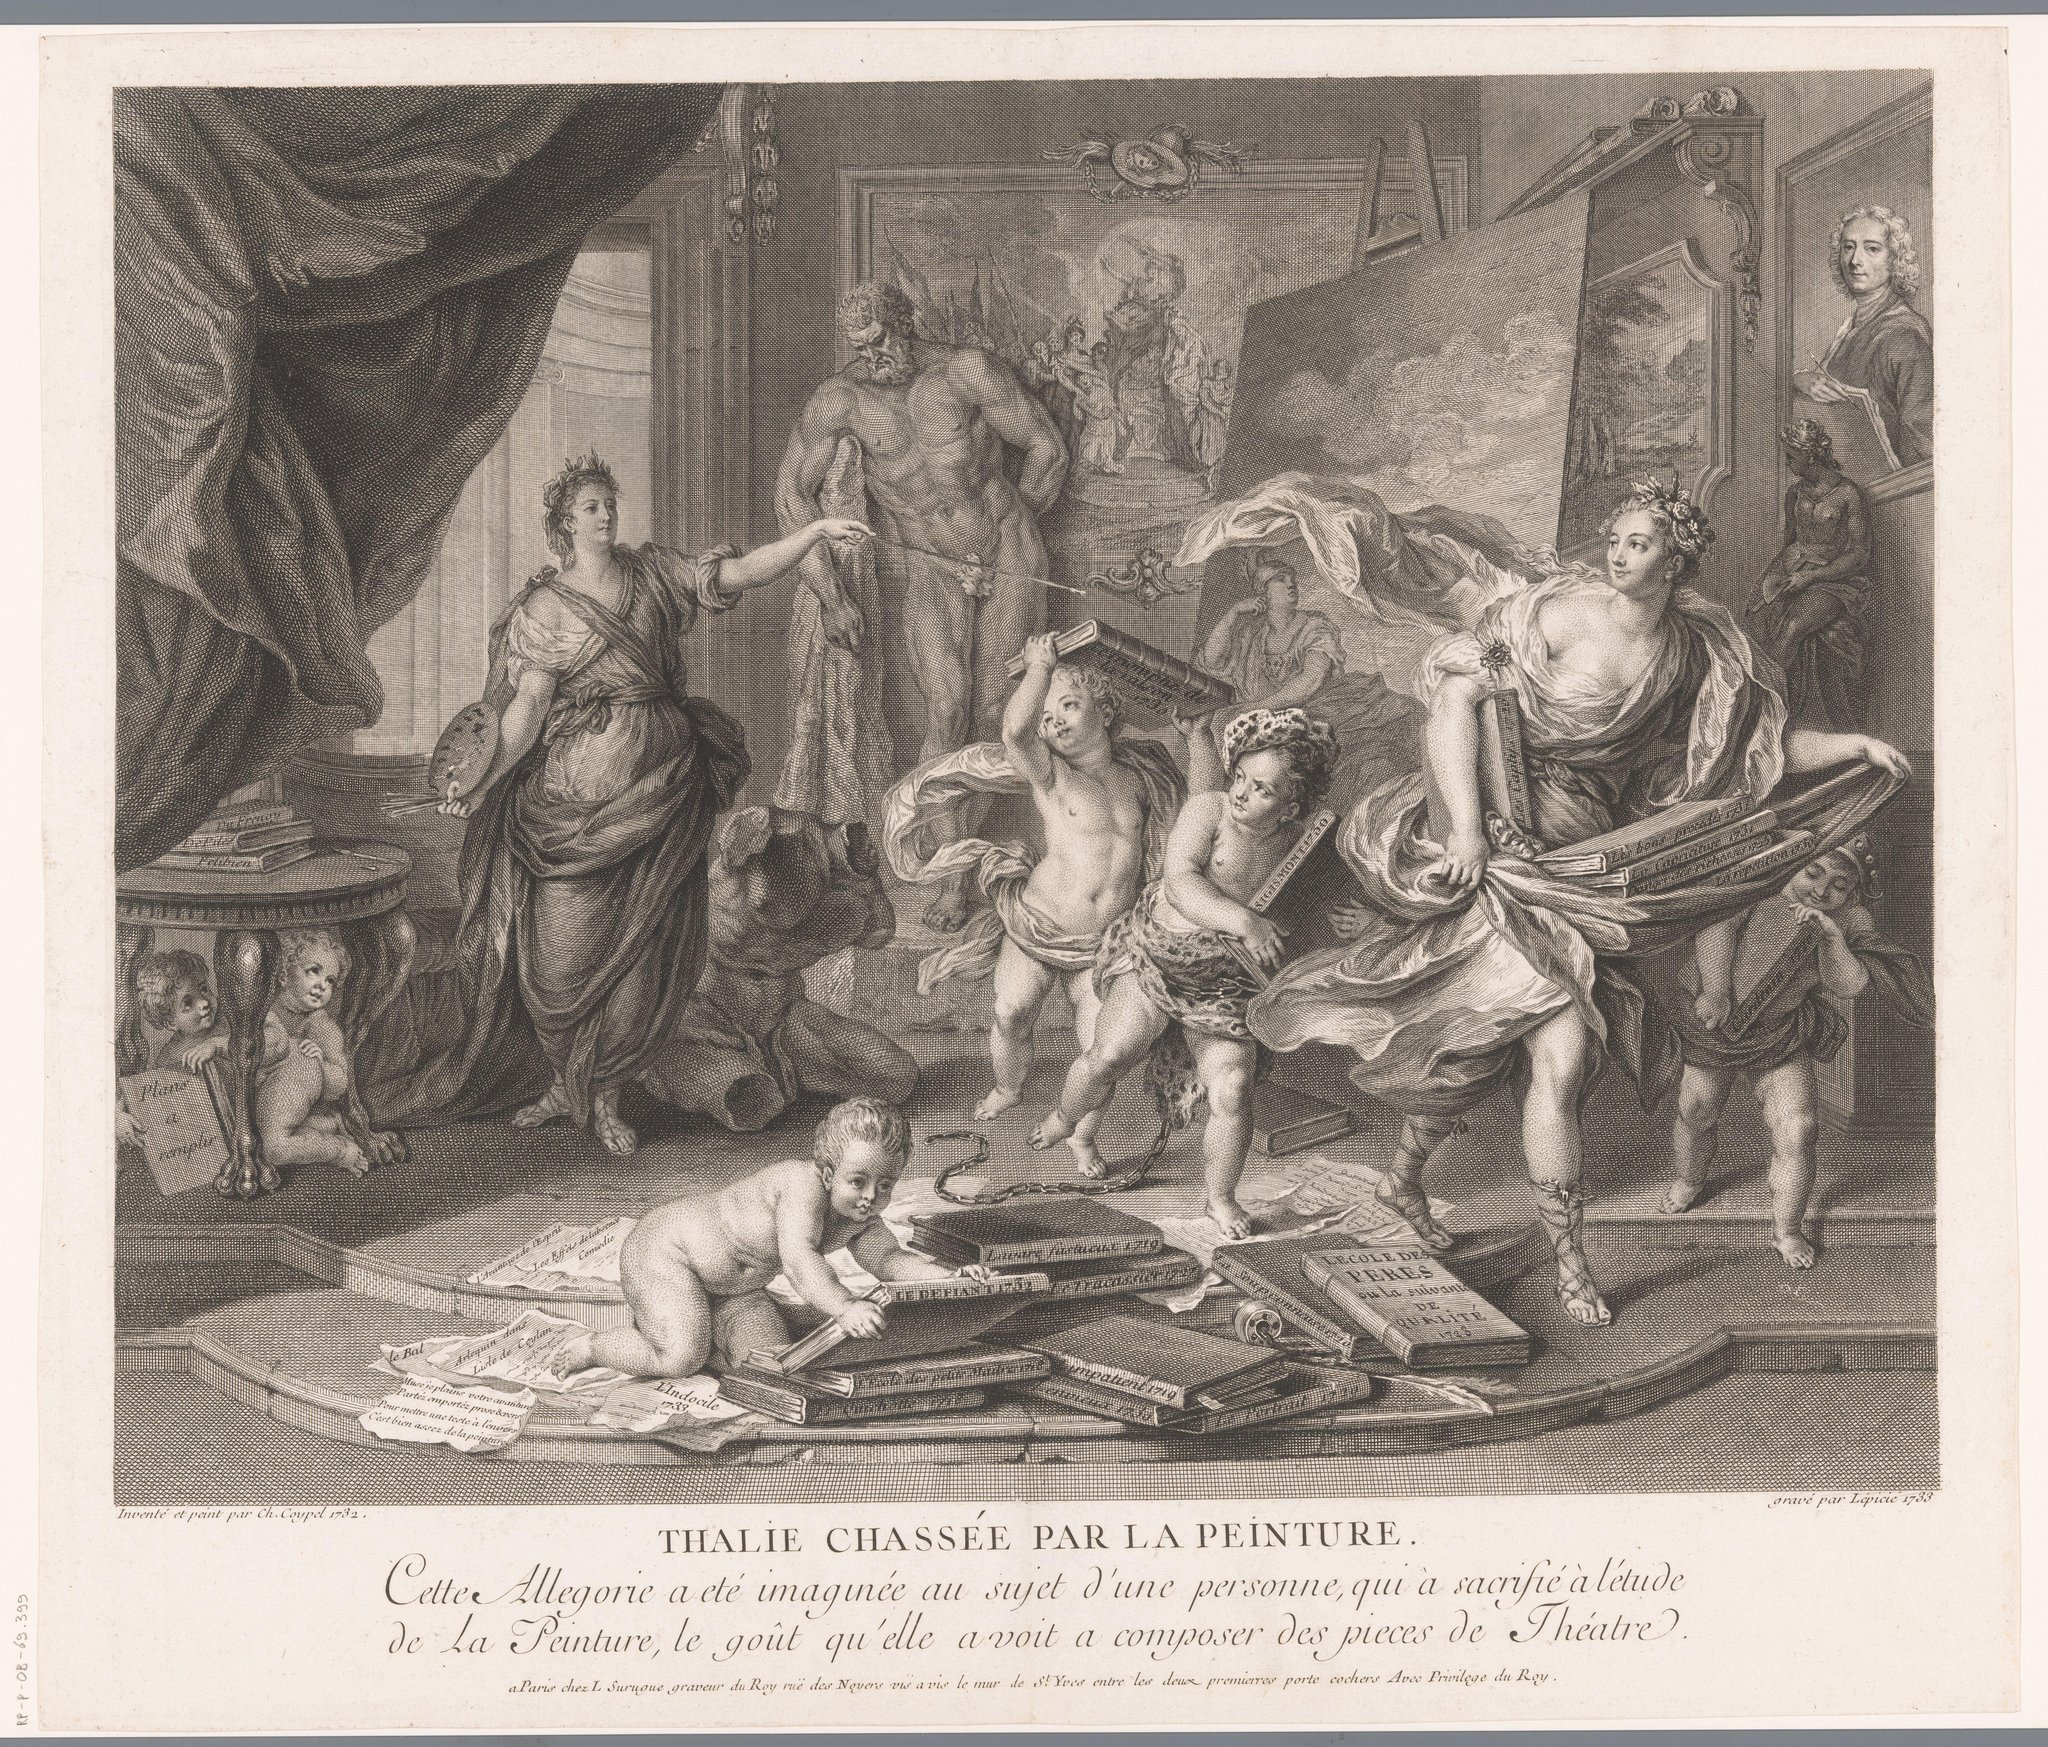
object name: print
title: Thalie chassée par la Peinture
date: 1733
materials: paper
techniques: engraving, etching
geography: france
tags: 'comedia', 'comedia vecchia' (ripa), 'pictura', symbolic representations, allegories and emblems ~ painting; 'pittura' (ripa), piece of sculpture, reproduction of a piece of sculpture, thalia (one of the muses); 'talia' (ripa)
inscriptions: collector's mark: Lugt 240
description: De muze Thalia, een stapel boeken dragend, wordt weggejaagd door de Schilderkunst. Deze heeft de gedaante van een vrouw met palet en penselen in de ene, een schilderstok in de andere hand. Naast de Schilderkunst een gebeeldhouwde tors. De Hercules Farnese staat voor een schilderij. Rechts aan de muur het portret van een schilder. De vloer ligt bezaaid met vroeg 18de-eeuwse uitgaven van toneelstukken.